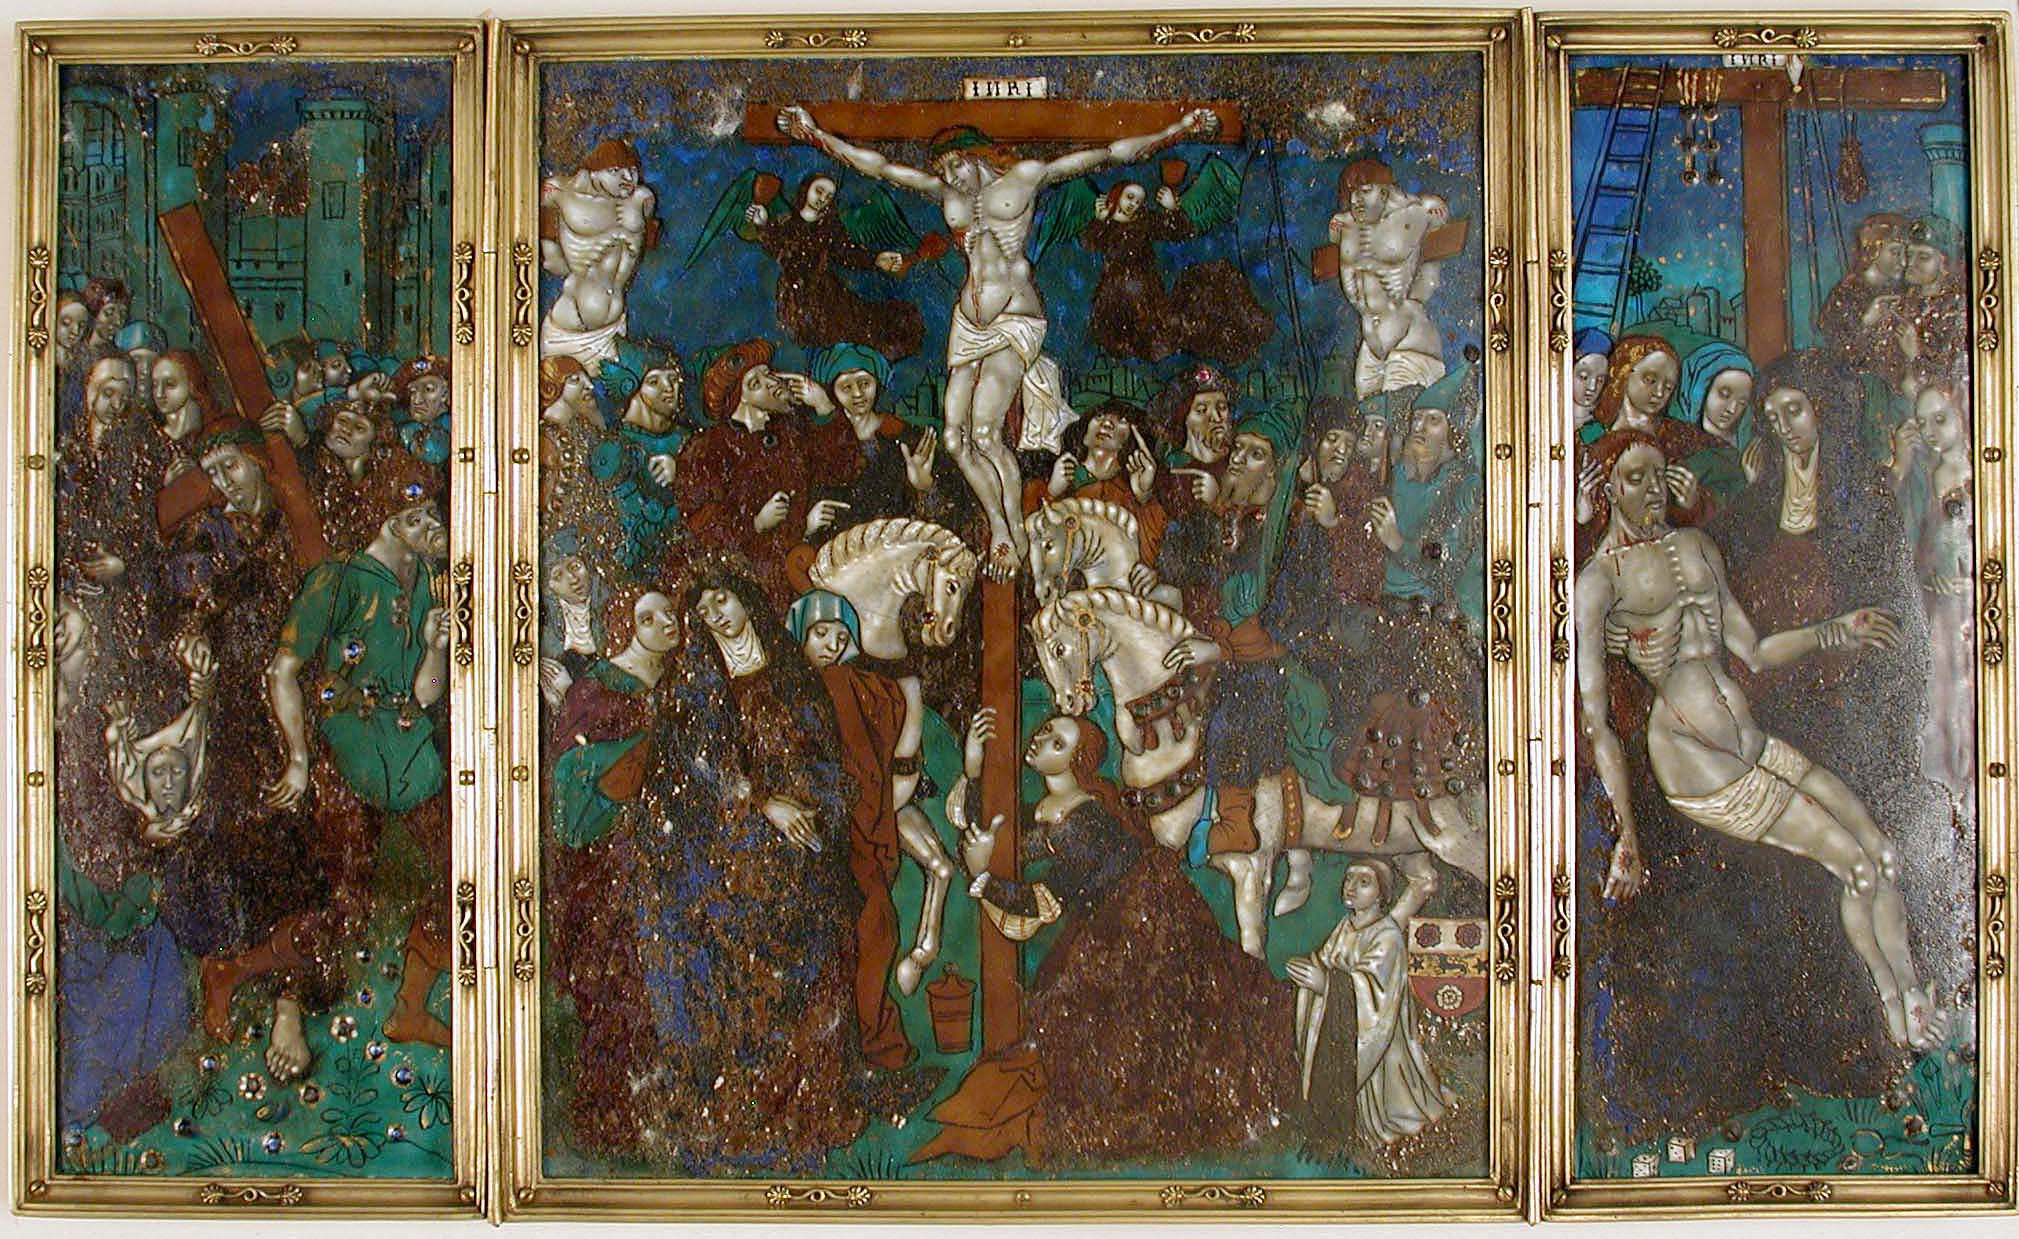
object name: triptych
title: Triptych with The Way to Calvary, Crucifixion, and Descent from the Cross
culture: french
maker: jean pénicaud i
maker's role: artist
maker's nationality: french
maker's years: 1490-1543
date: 1501-1600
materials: copper, enamel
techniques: painting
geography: france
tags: christ,descent from the cross